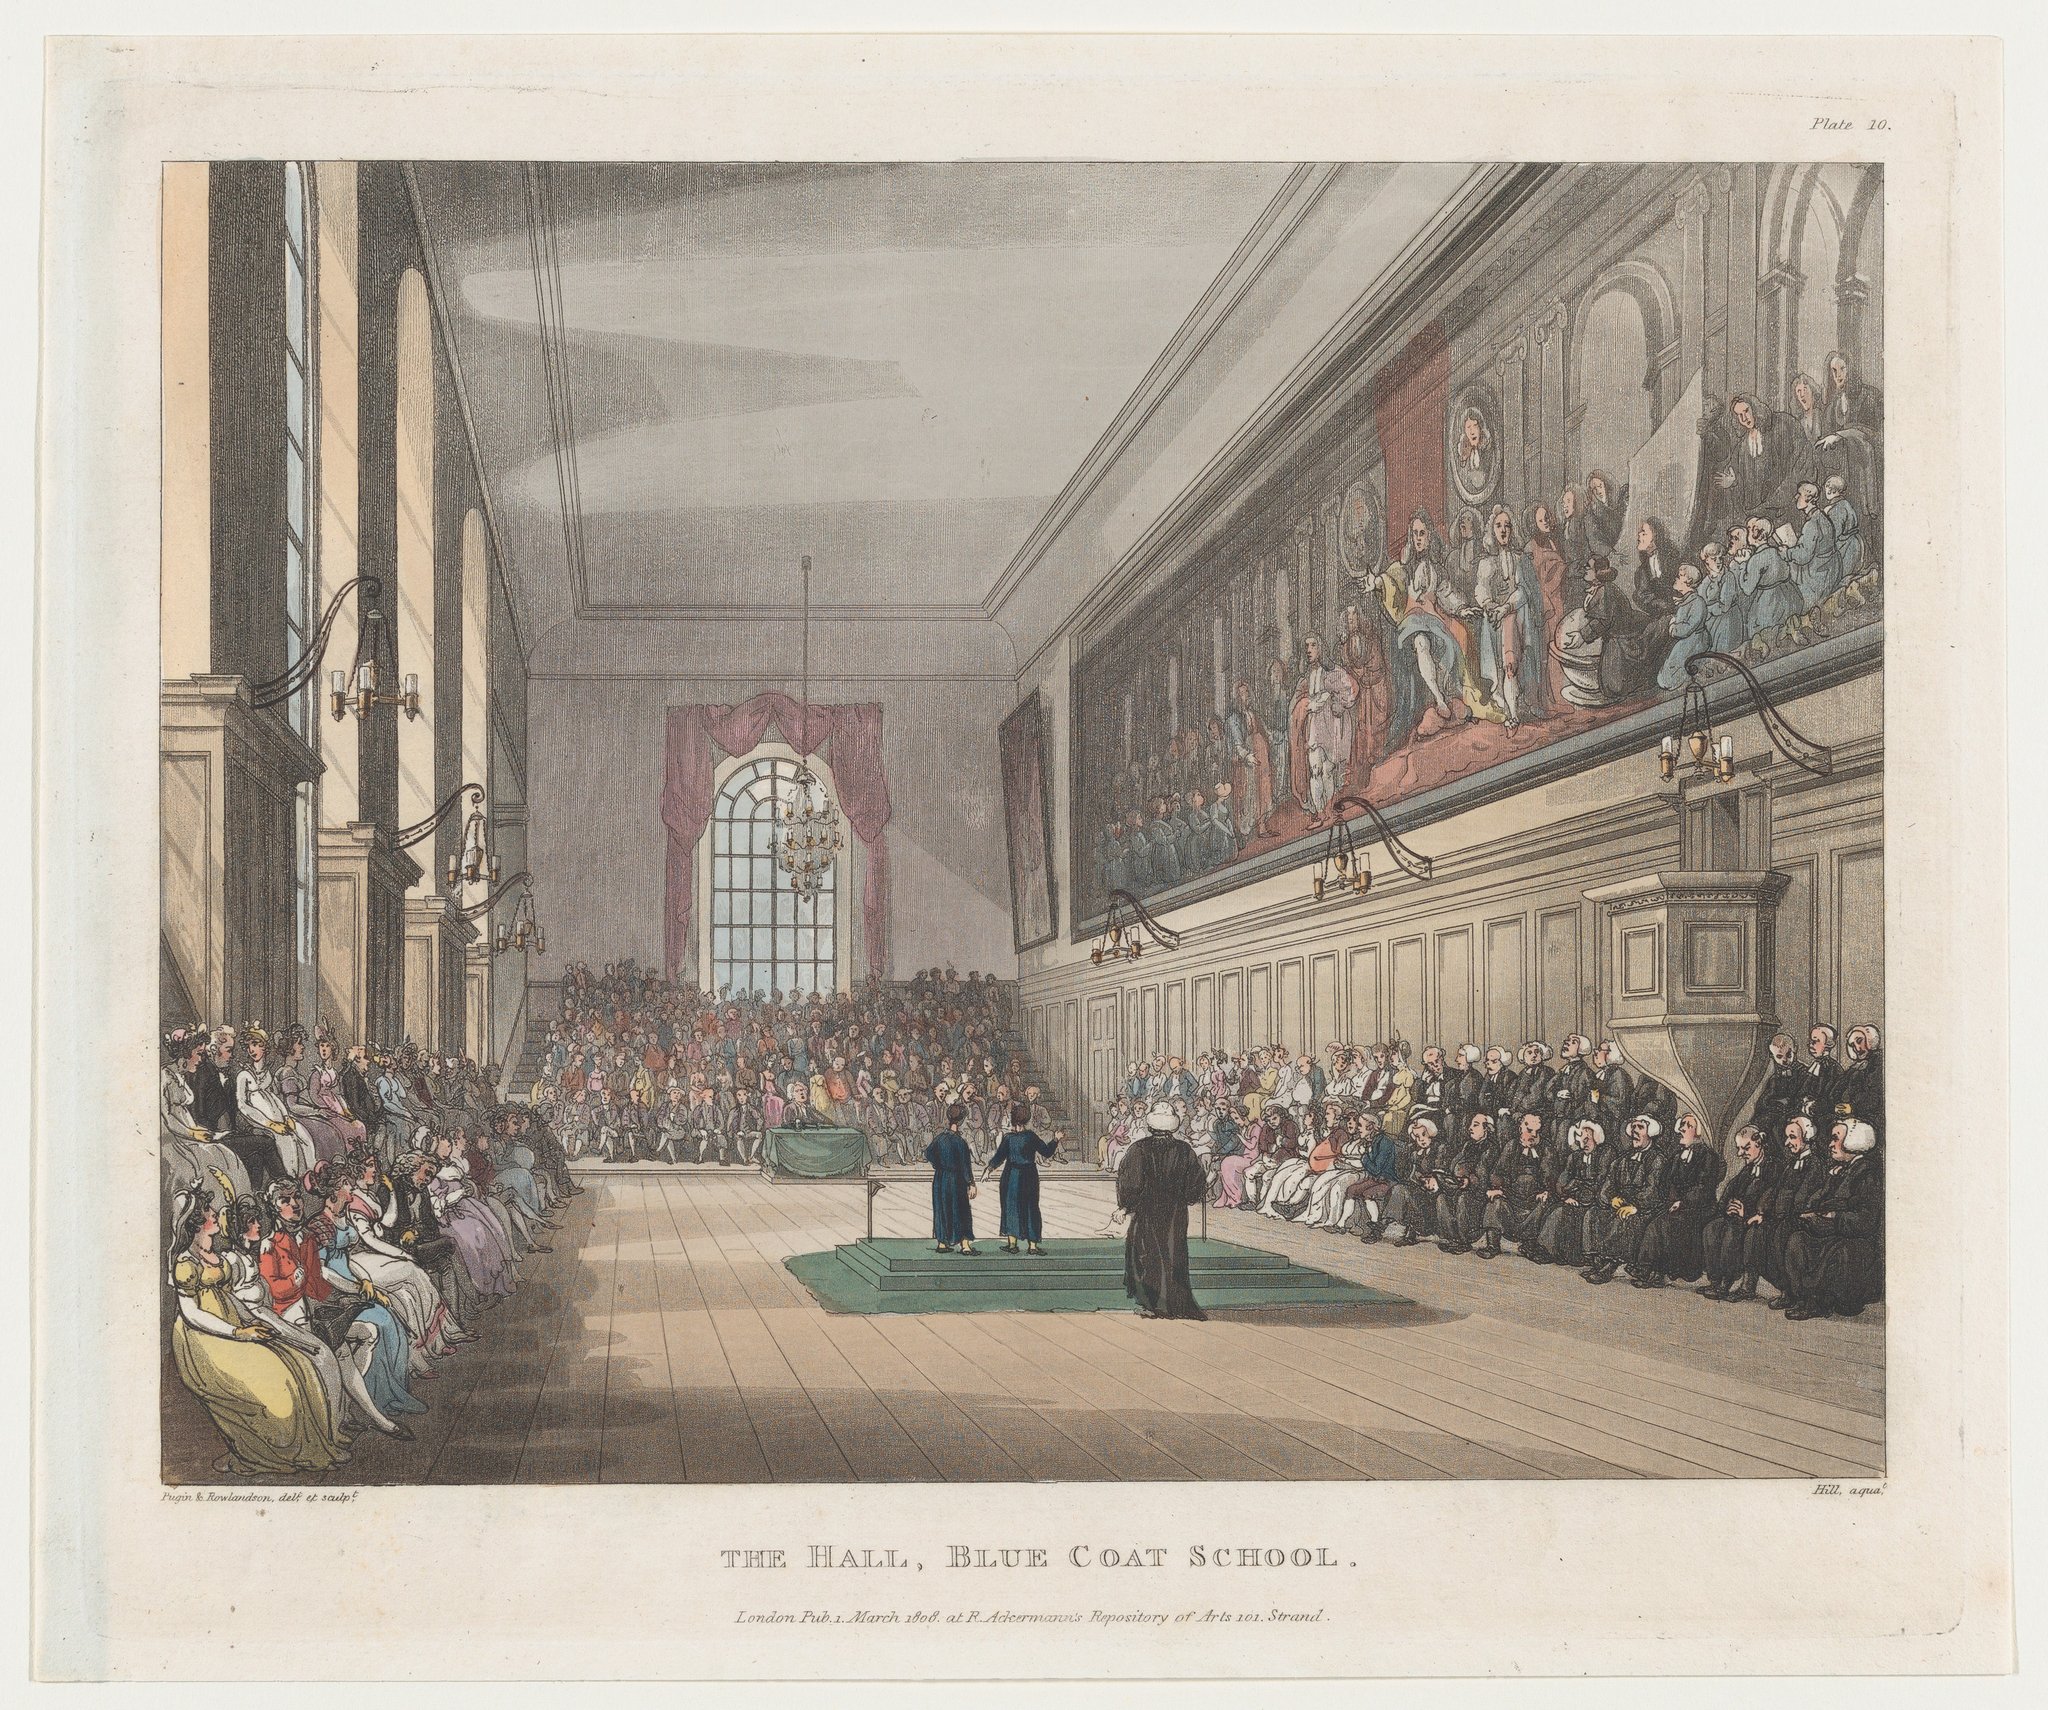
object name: print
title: The Hall, Blue Coat School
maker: thomas rowlandson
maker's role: artist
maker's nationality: british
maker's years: 1757-1827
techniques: aquatint, etching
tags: interiors,spectators